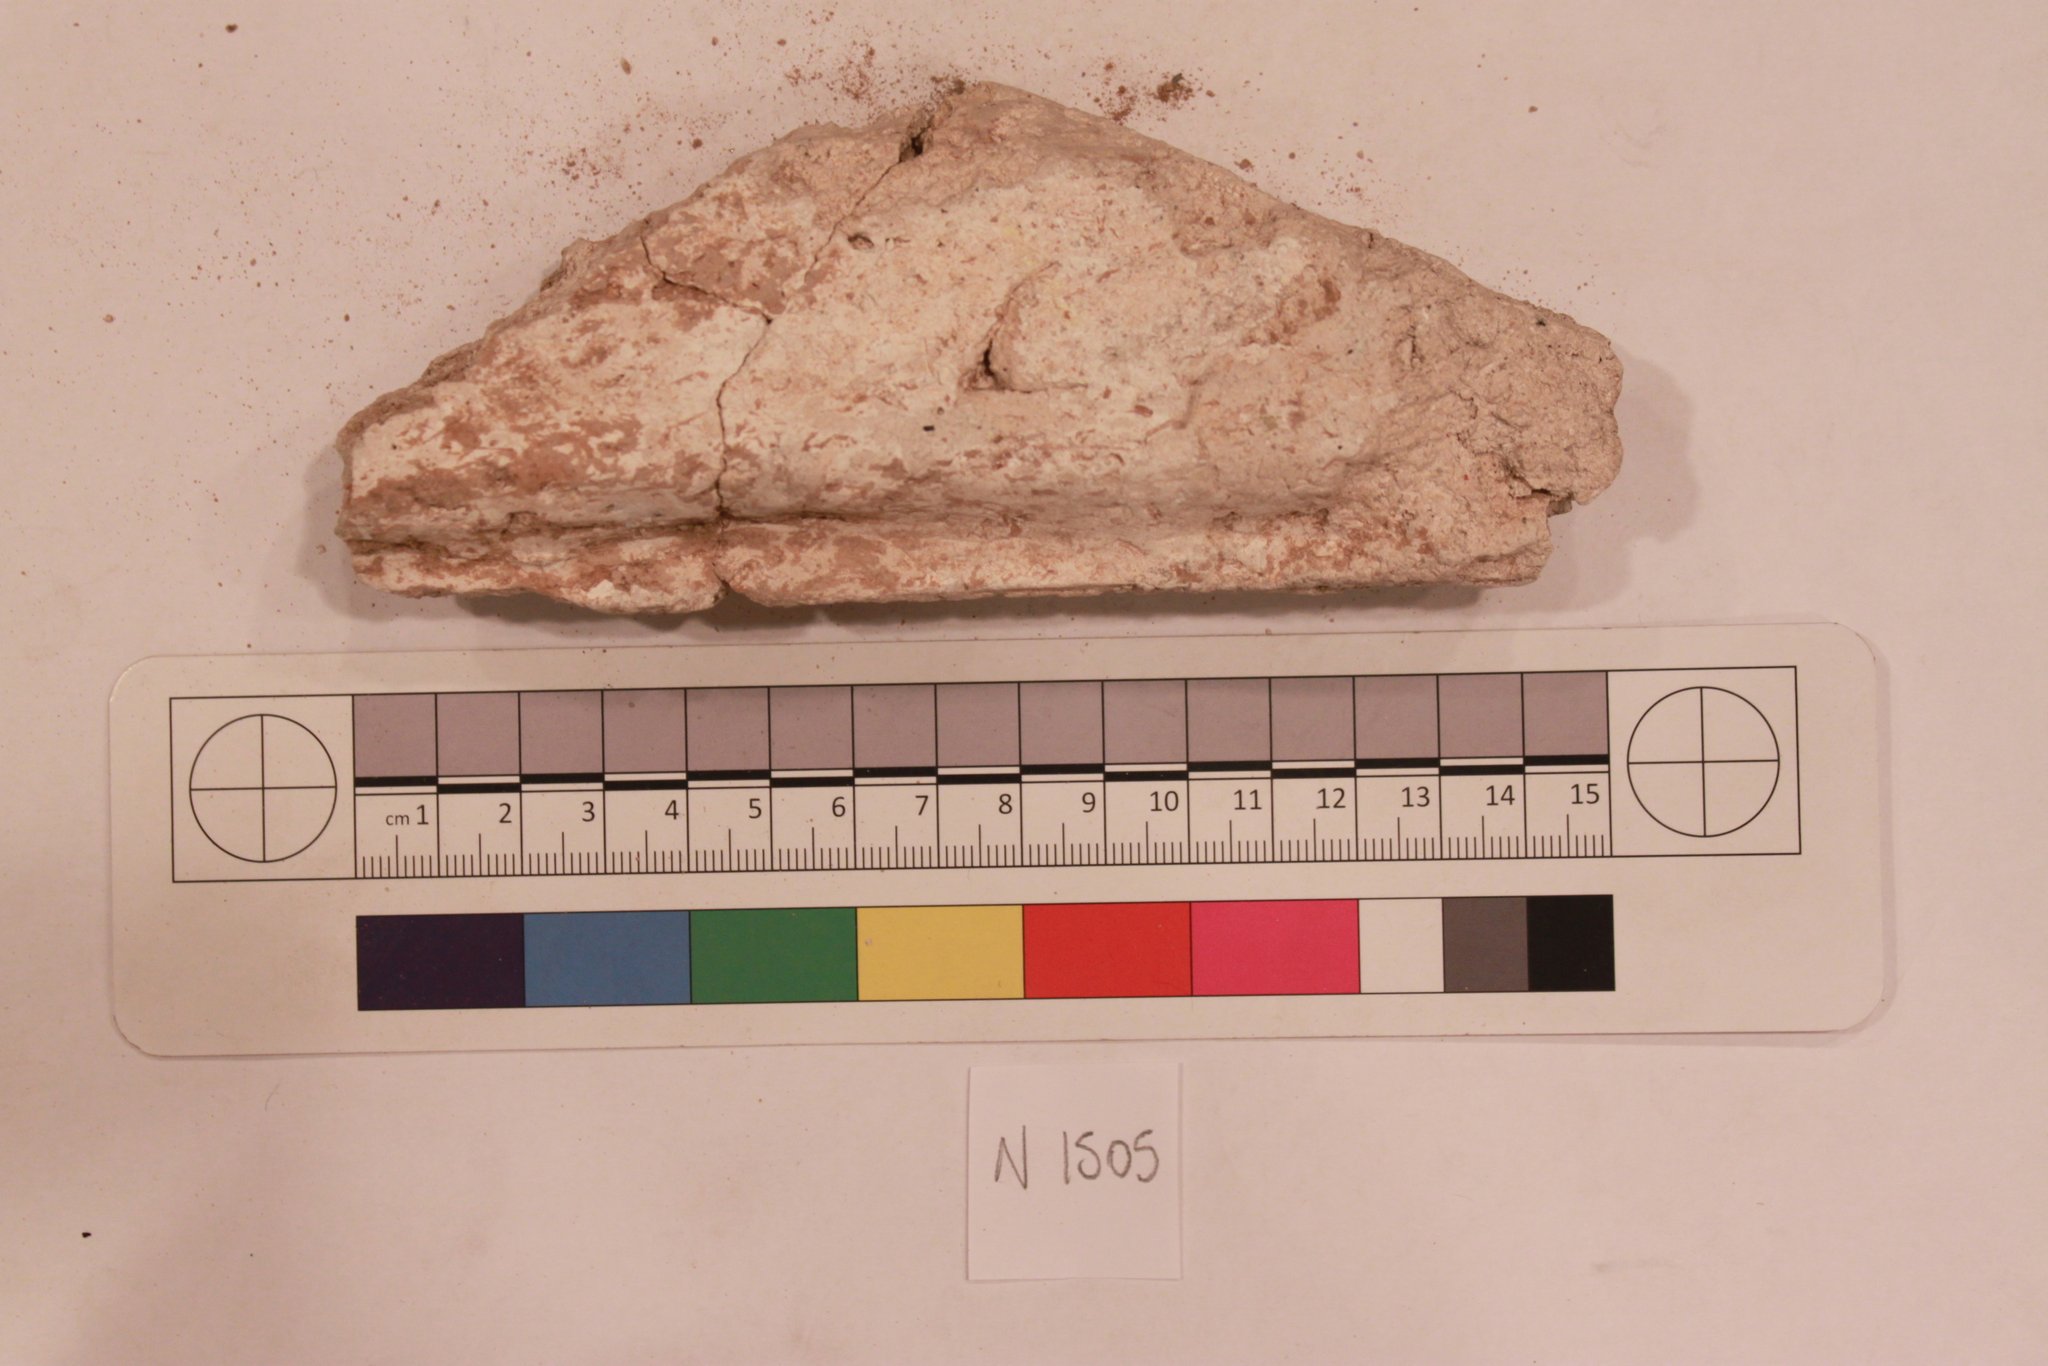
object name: fragment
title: Stucco Fragment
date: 701-1200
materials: plaster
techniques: carving, painting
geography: iran